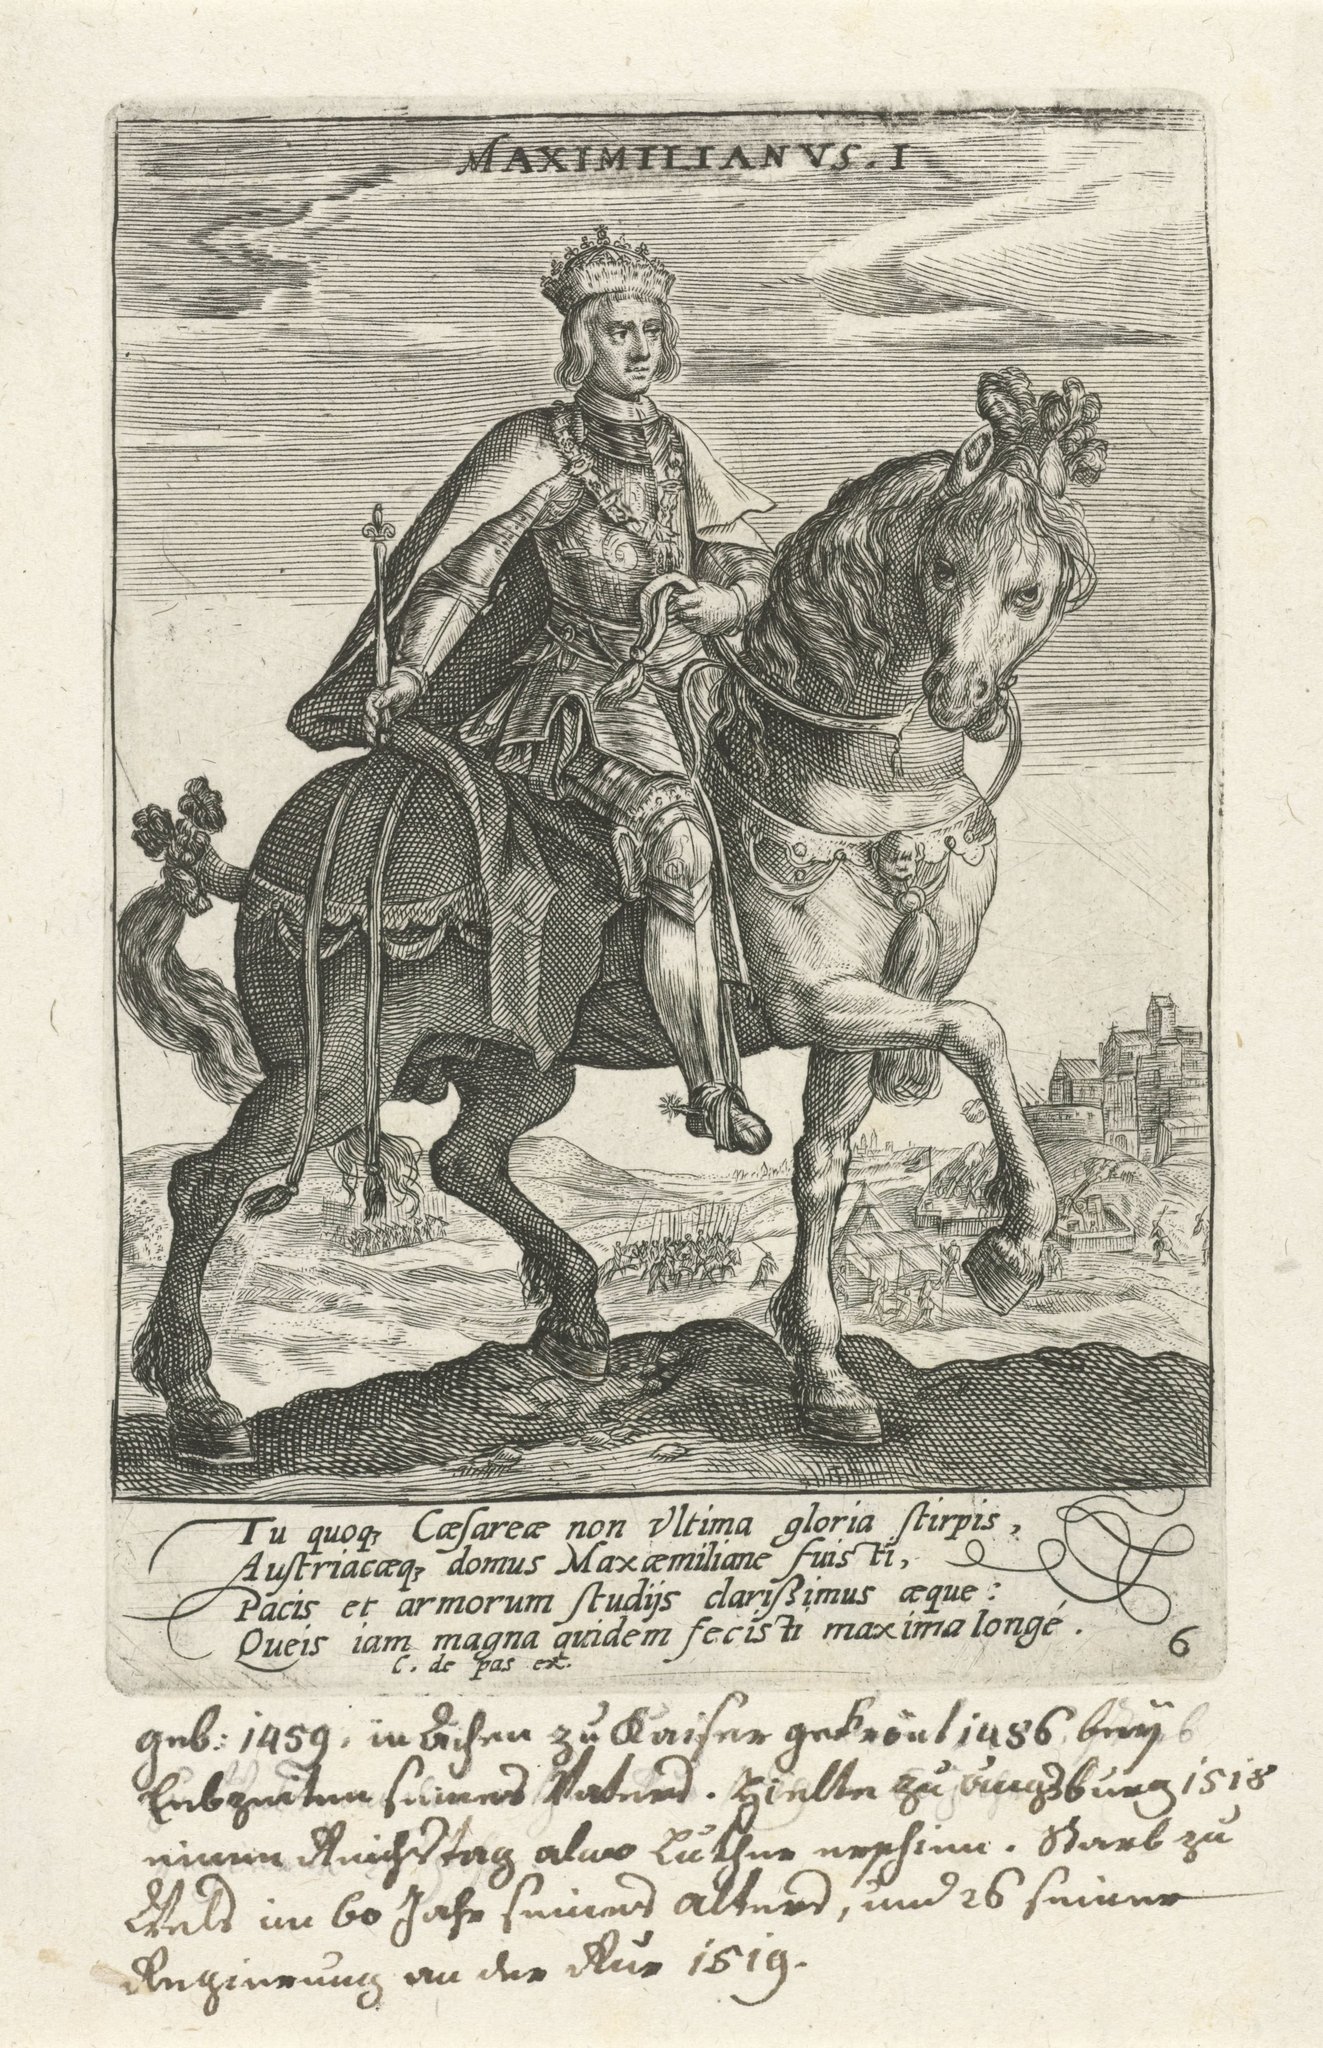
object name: print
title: Ruiterportret van keizer Maximiliaan I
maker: crispijn van de passe (i)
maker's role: draughtsman, print maker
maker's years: 1564-1637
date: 1604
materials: paper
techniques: engraving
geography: cologne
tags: maximilian i (holy roman emperor), knighthood order of the golden fleece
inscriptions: inscription, collector's mark: Lugt 2773, collector's mark: Lugt 2228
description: Maximiliaan I van Habsburg, Rooms-Duits keizer, te paard. Hij draagt een keten met de Orde van het Gulden Vlies. Op de achtergrond de belegering van een stad. In de marge een vierregelig onderschrift in het Latijn. Prent uit een serie met Duitse keizers te paard.